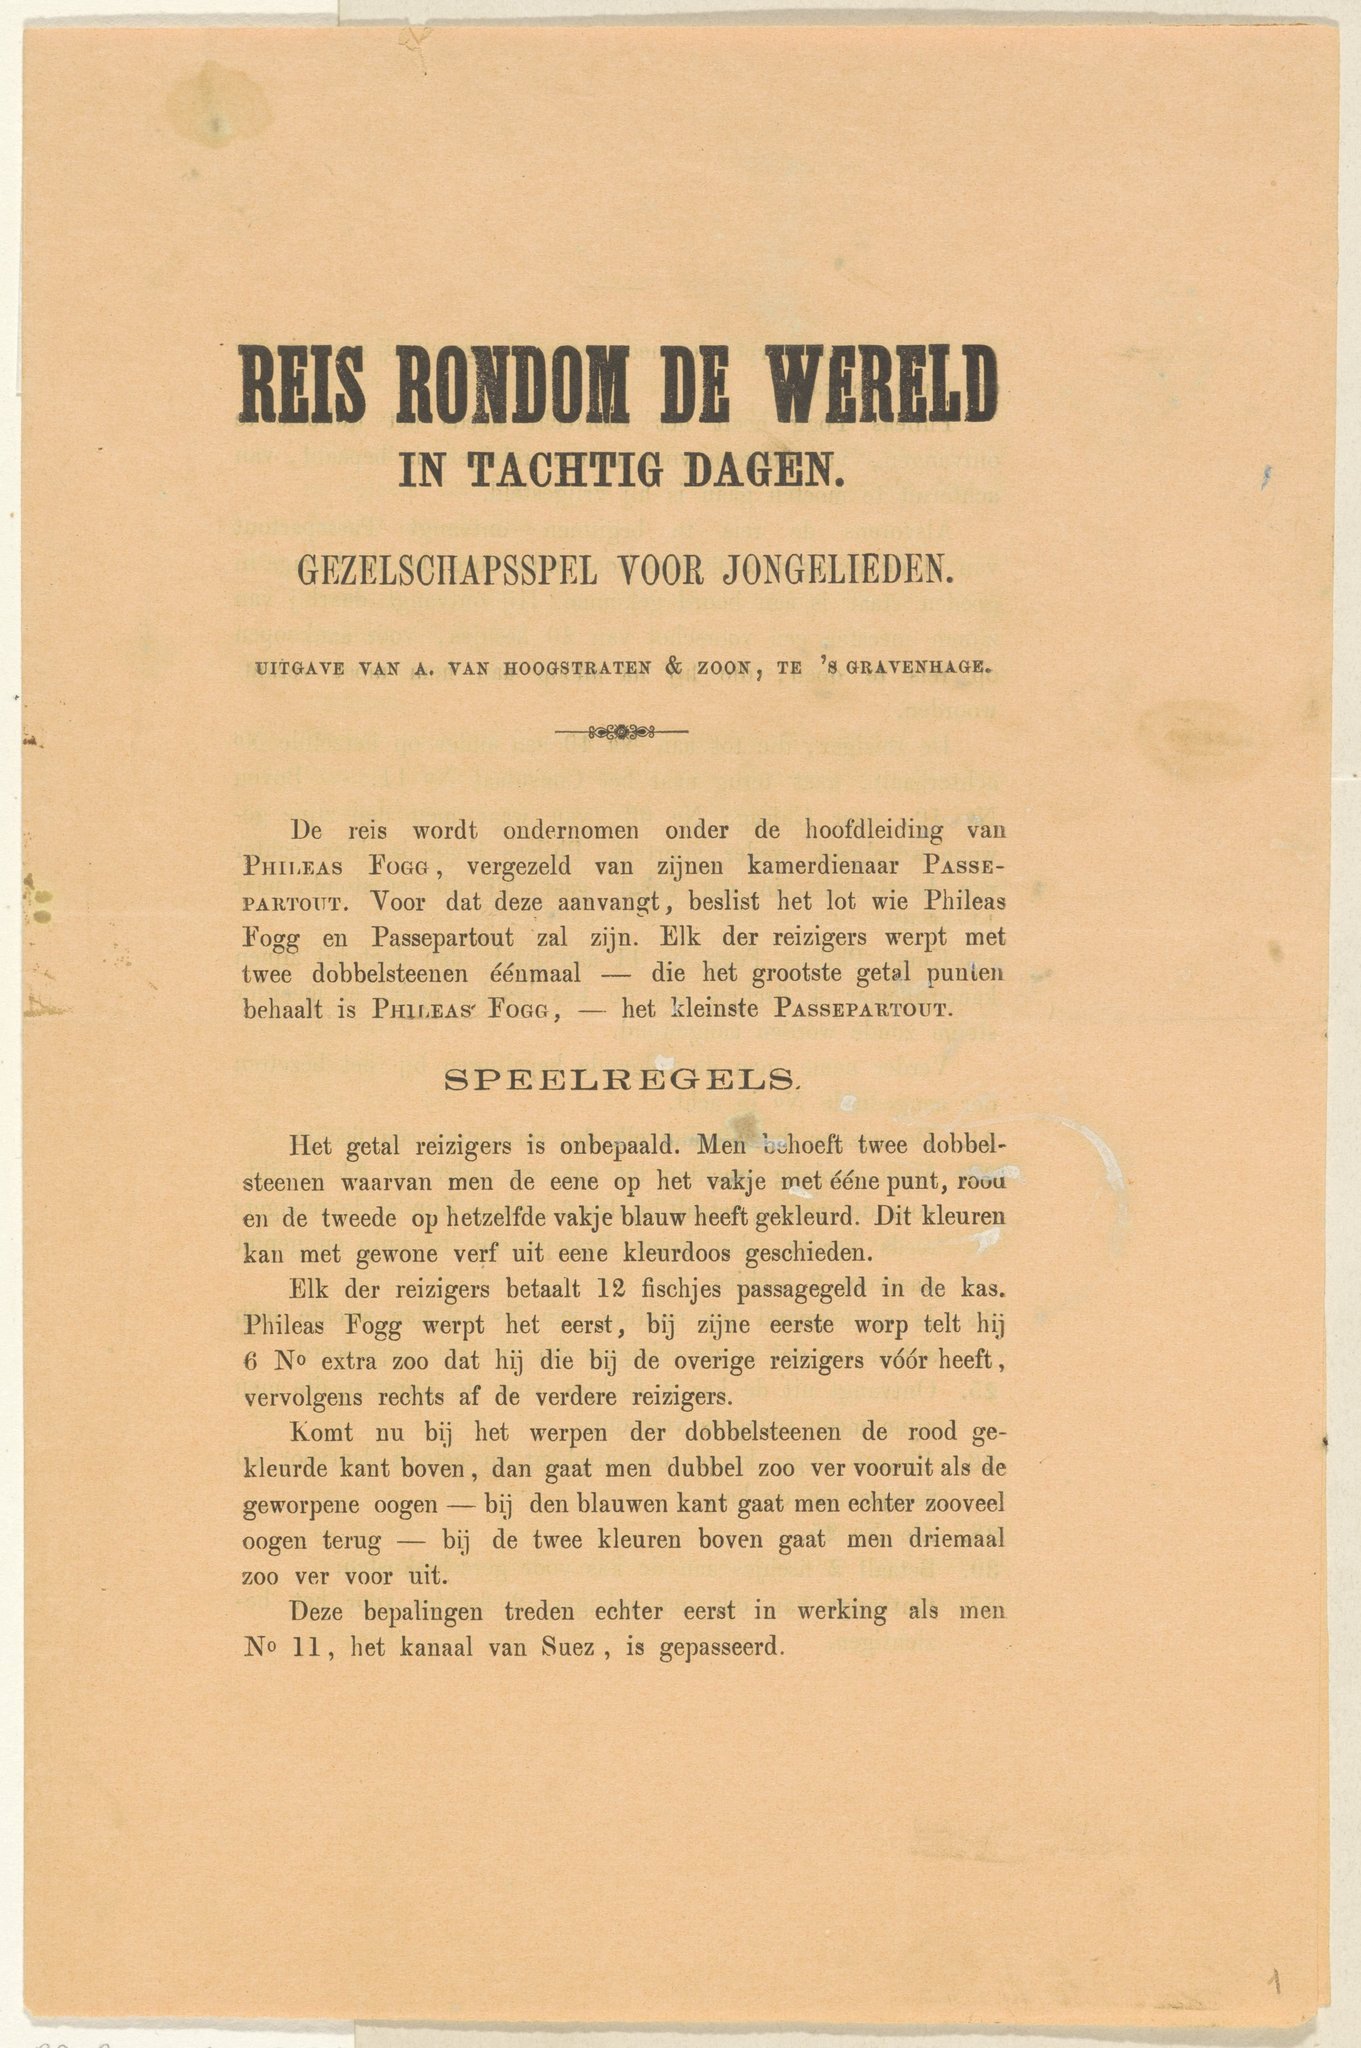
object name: text sheet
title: Spelregels bij het bordspel: Verne's reis om de wereld in tachtig dagen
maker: Anonymous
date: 1876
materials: paper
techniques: letterpress printing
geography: netherlands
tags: board-games of chance, board-games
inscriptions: collector's mark: Lugt 2760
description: Spelregels bij het bordspel: Verne's reis om de wereld in tachtig dagen in boekdruk.